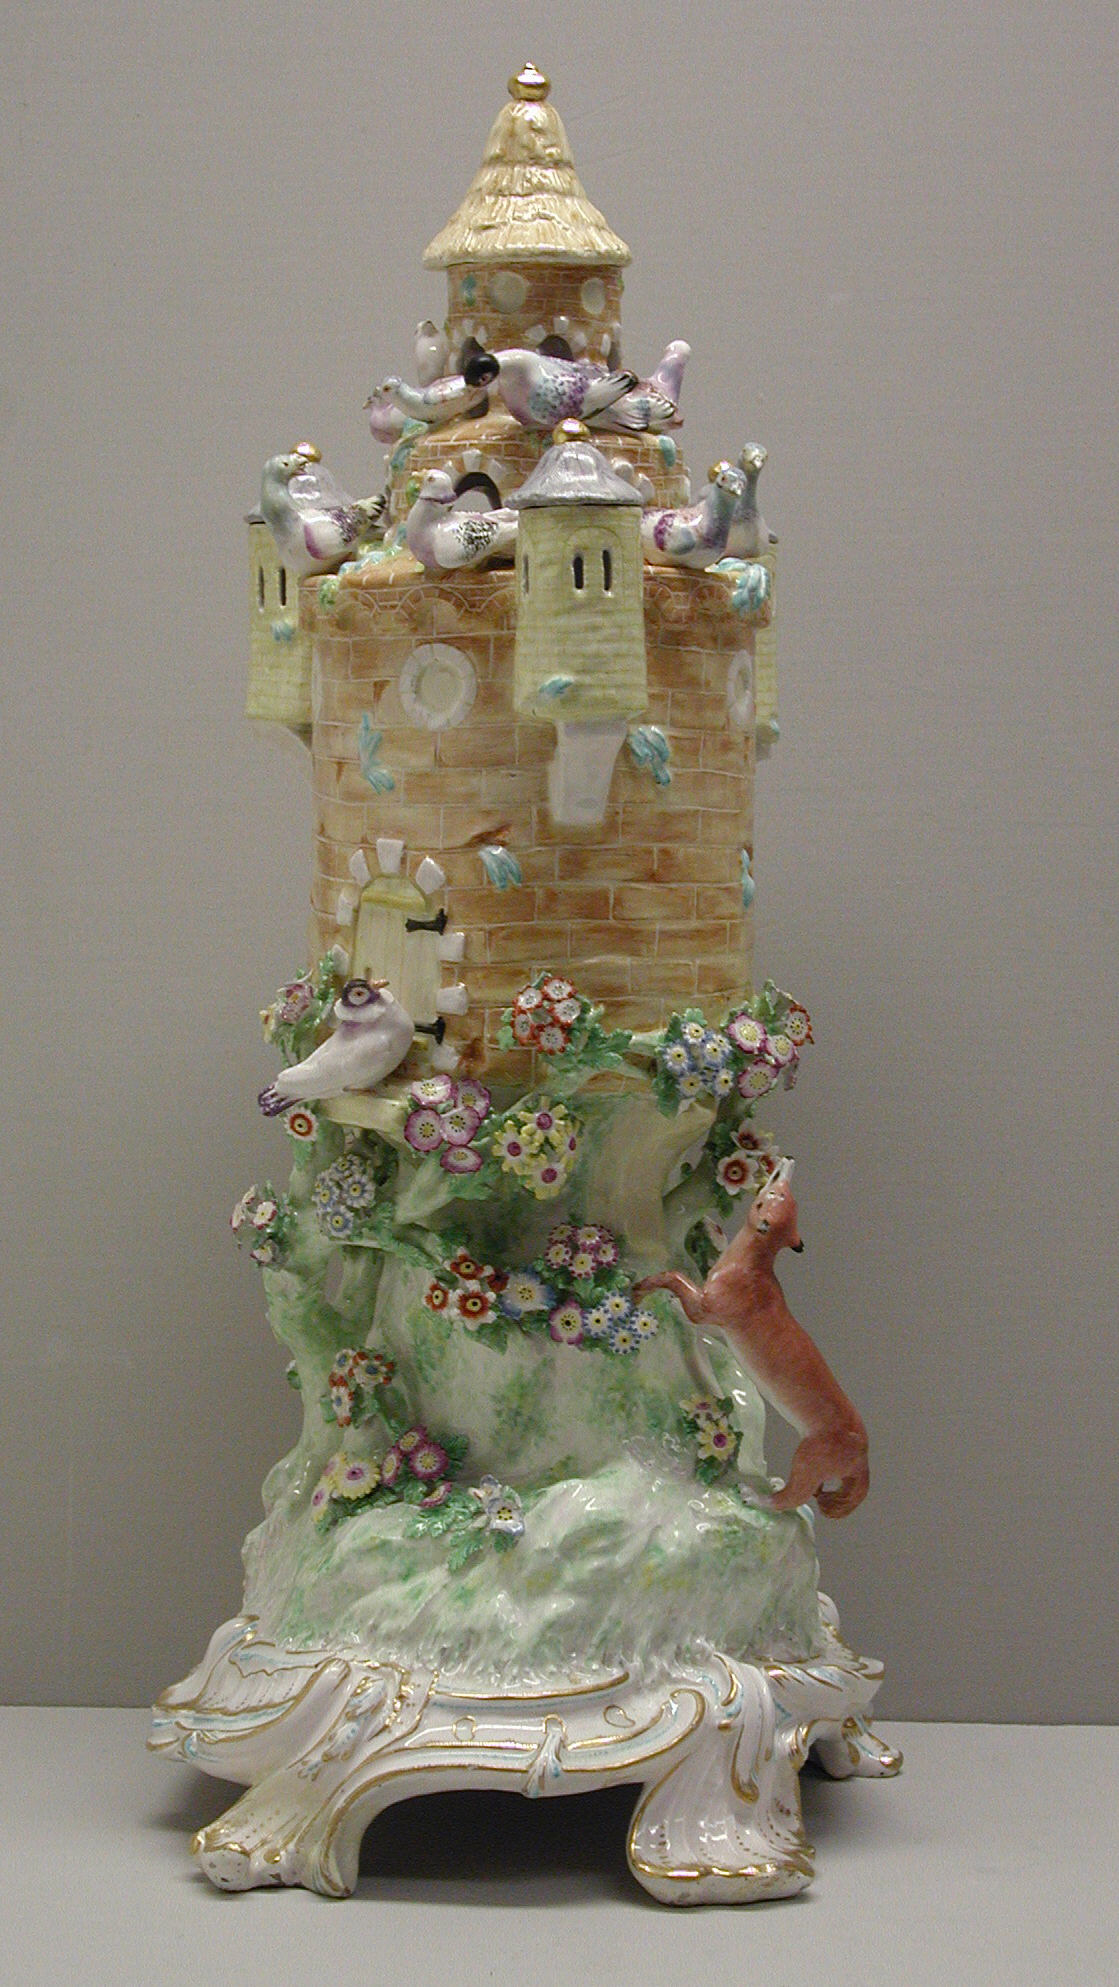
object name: perfume burner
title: Perfume burner in the form of a dove-cote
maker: chelsea porcelain manufactory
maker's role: factory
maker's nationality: british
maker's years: 1744-1784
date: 1759-1765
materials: soft paste porcelain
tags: animals,pigeons,foxes,flowers